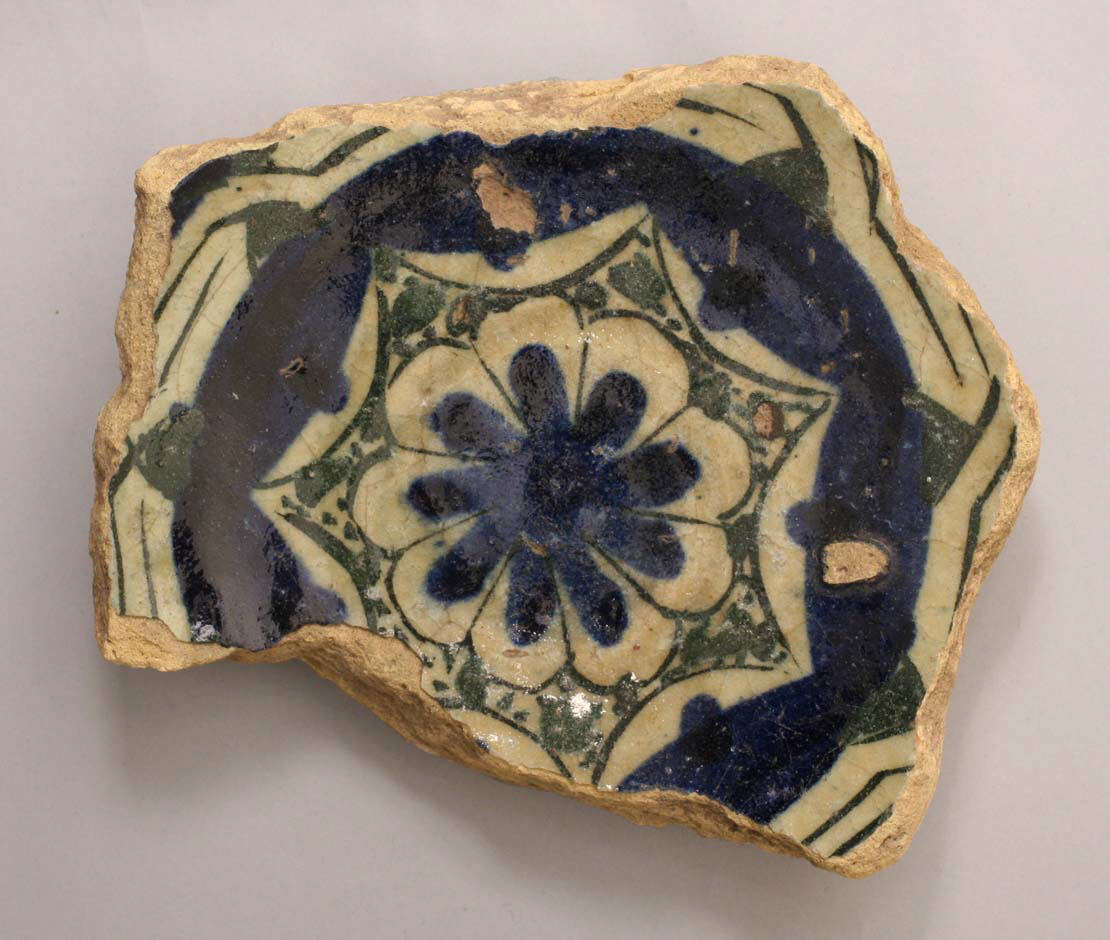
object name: ceramic fragment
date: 1401-1600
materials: glaze, stonepaste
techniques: painting, polychrome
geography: egypt